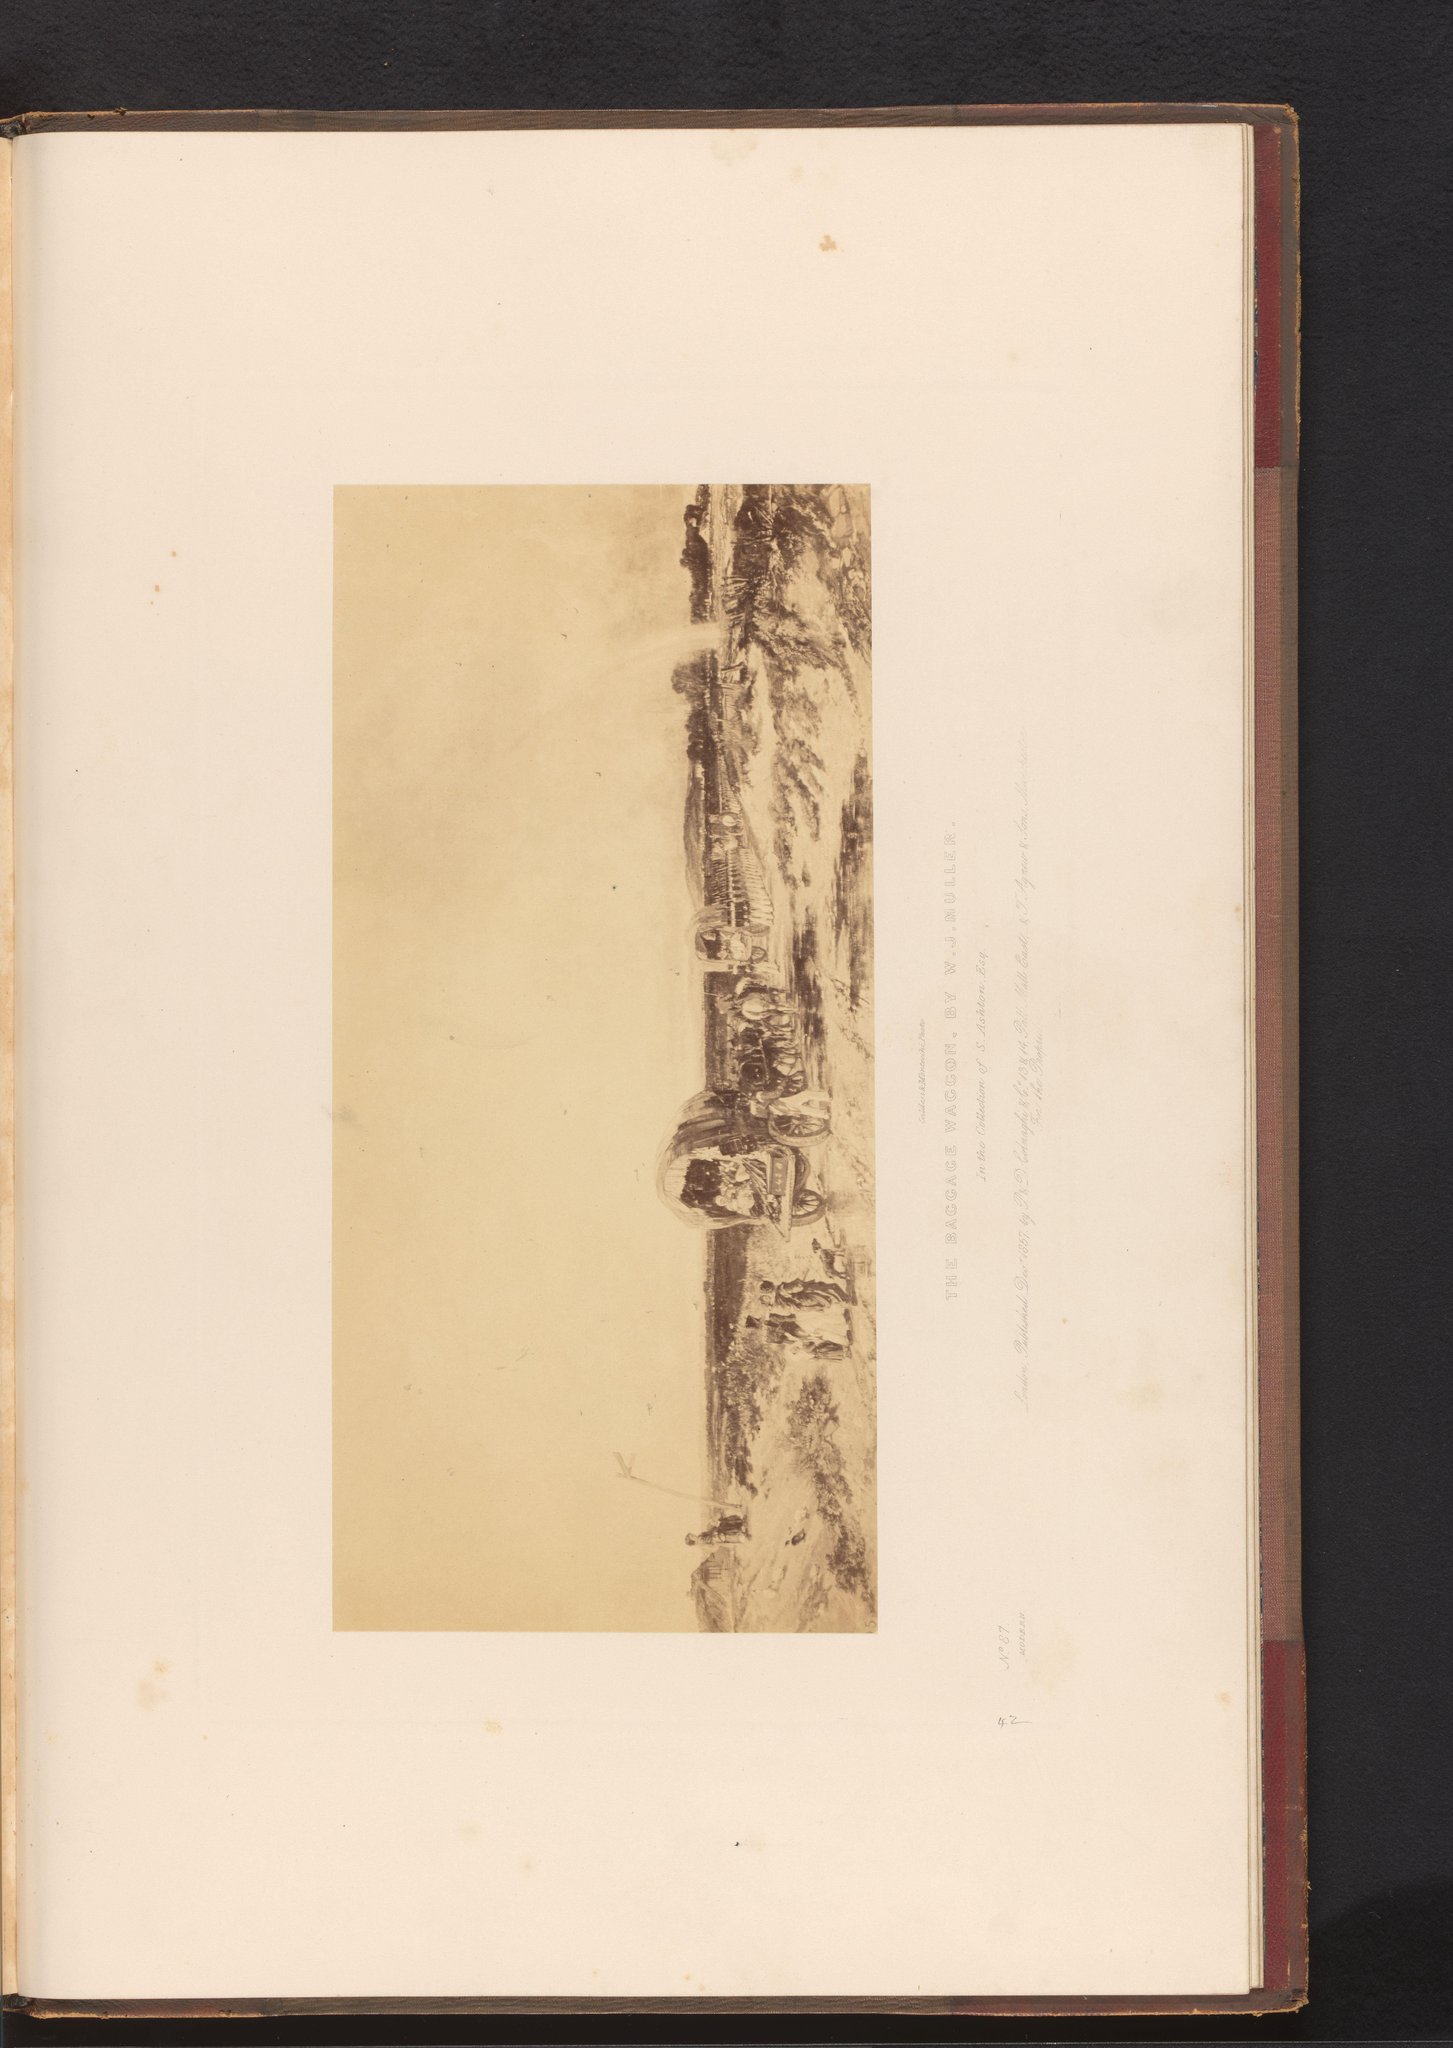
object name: page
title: Fotoreproductie van een schilderij van een karavaan reizigers door William James Muller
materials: photographic support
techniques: albumen print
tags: 'en route', traveller under way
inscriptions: inscription: ‘In the Collection of S. Ashton, Esq./ London, Published Decr, 1857, by P. & D. Colnaghi & Co, 13 & 14, Pall Mall East & T. Agneur & Sons, Manchester./ For the Proprietors.’, number: ‘No. 87./ MODERN.’, number: ‘42’